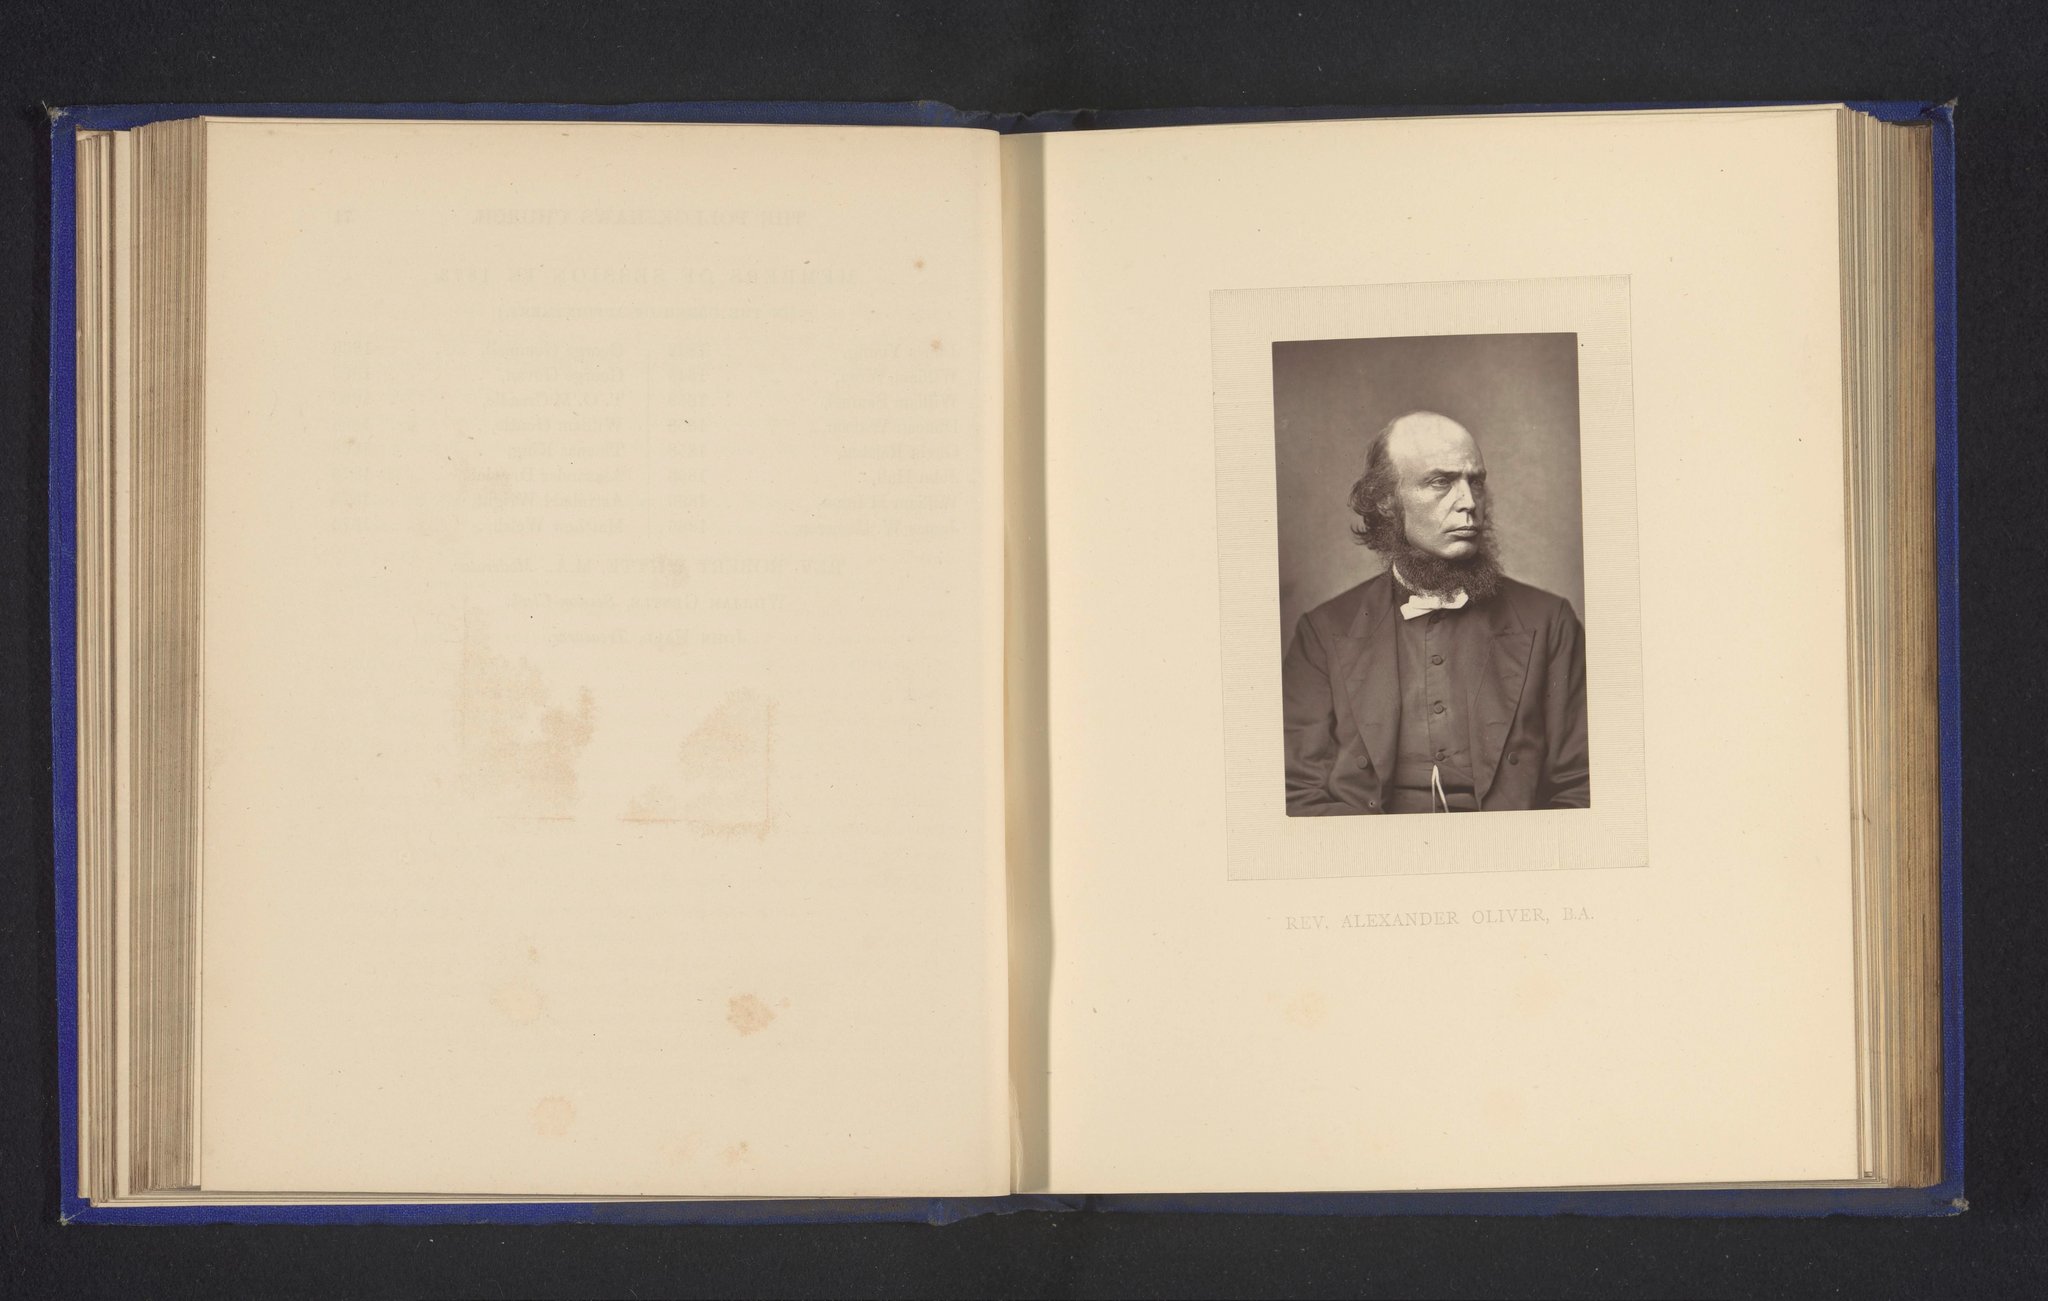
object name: page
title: Rev. Alexander Oliver, B.A.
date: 1865-1875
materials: paper, photographic support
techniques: carbon print, woodburytype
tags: functionaries and dignitaries (with name) ~ protestant churches